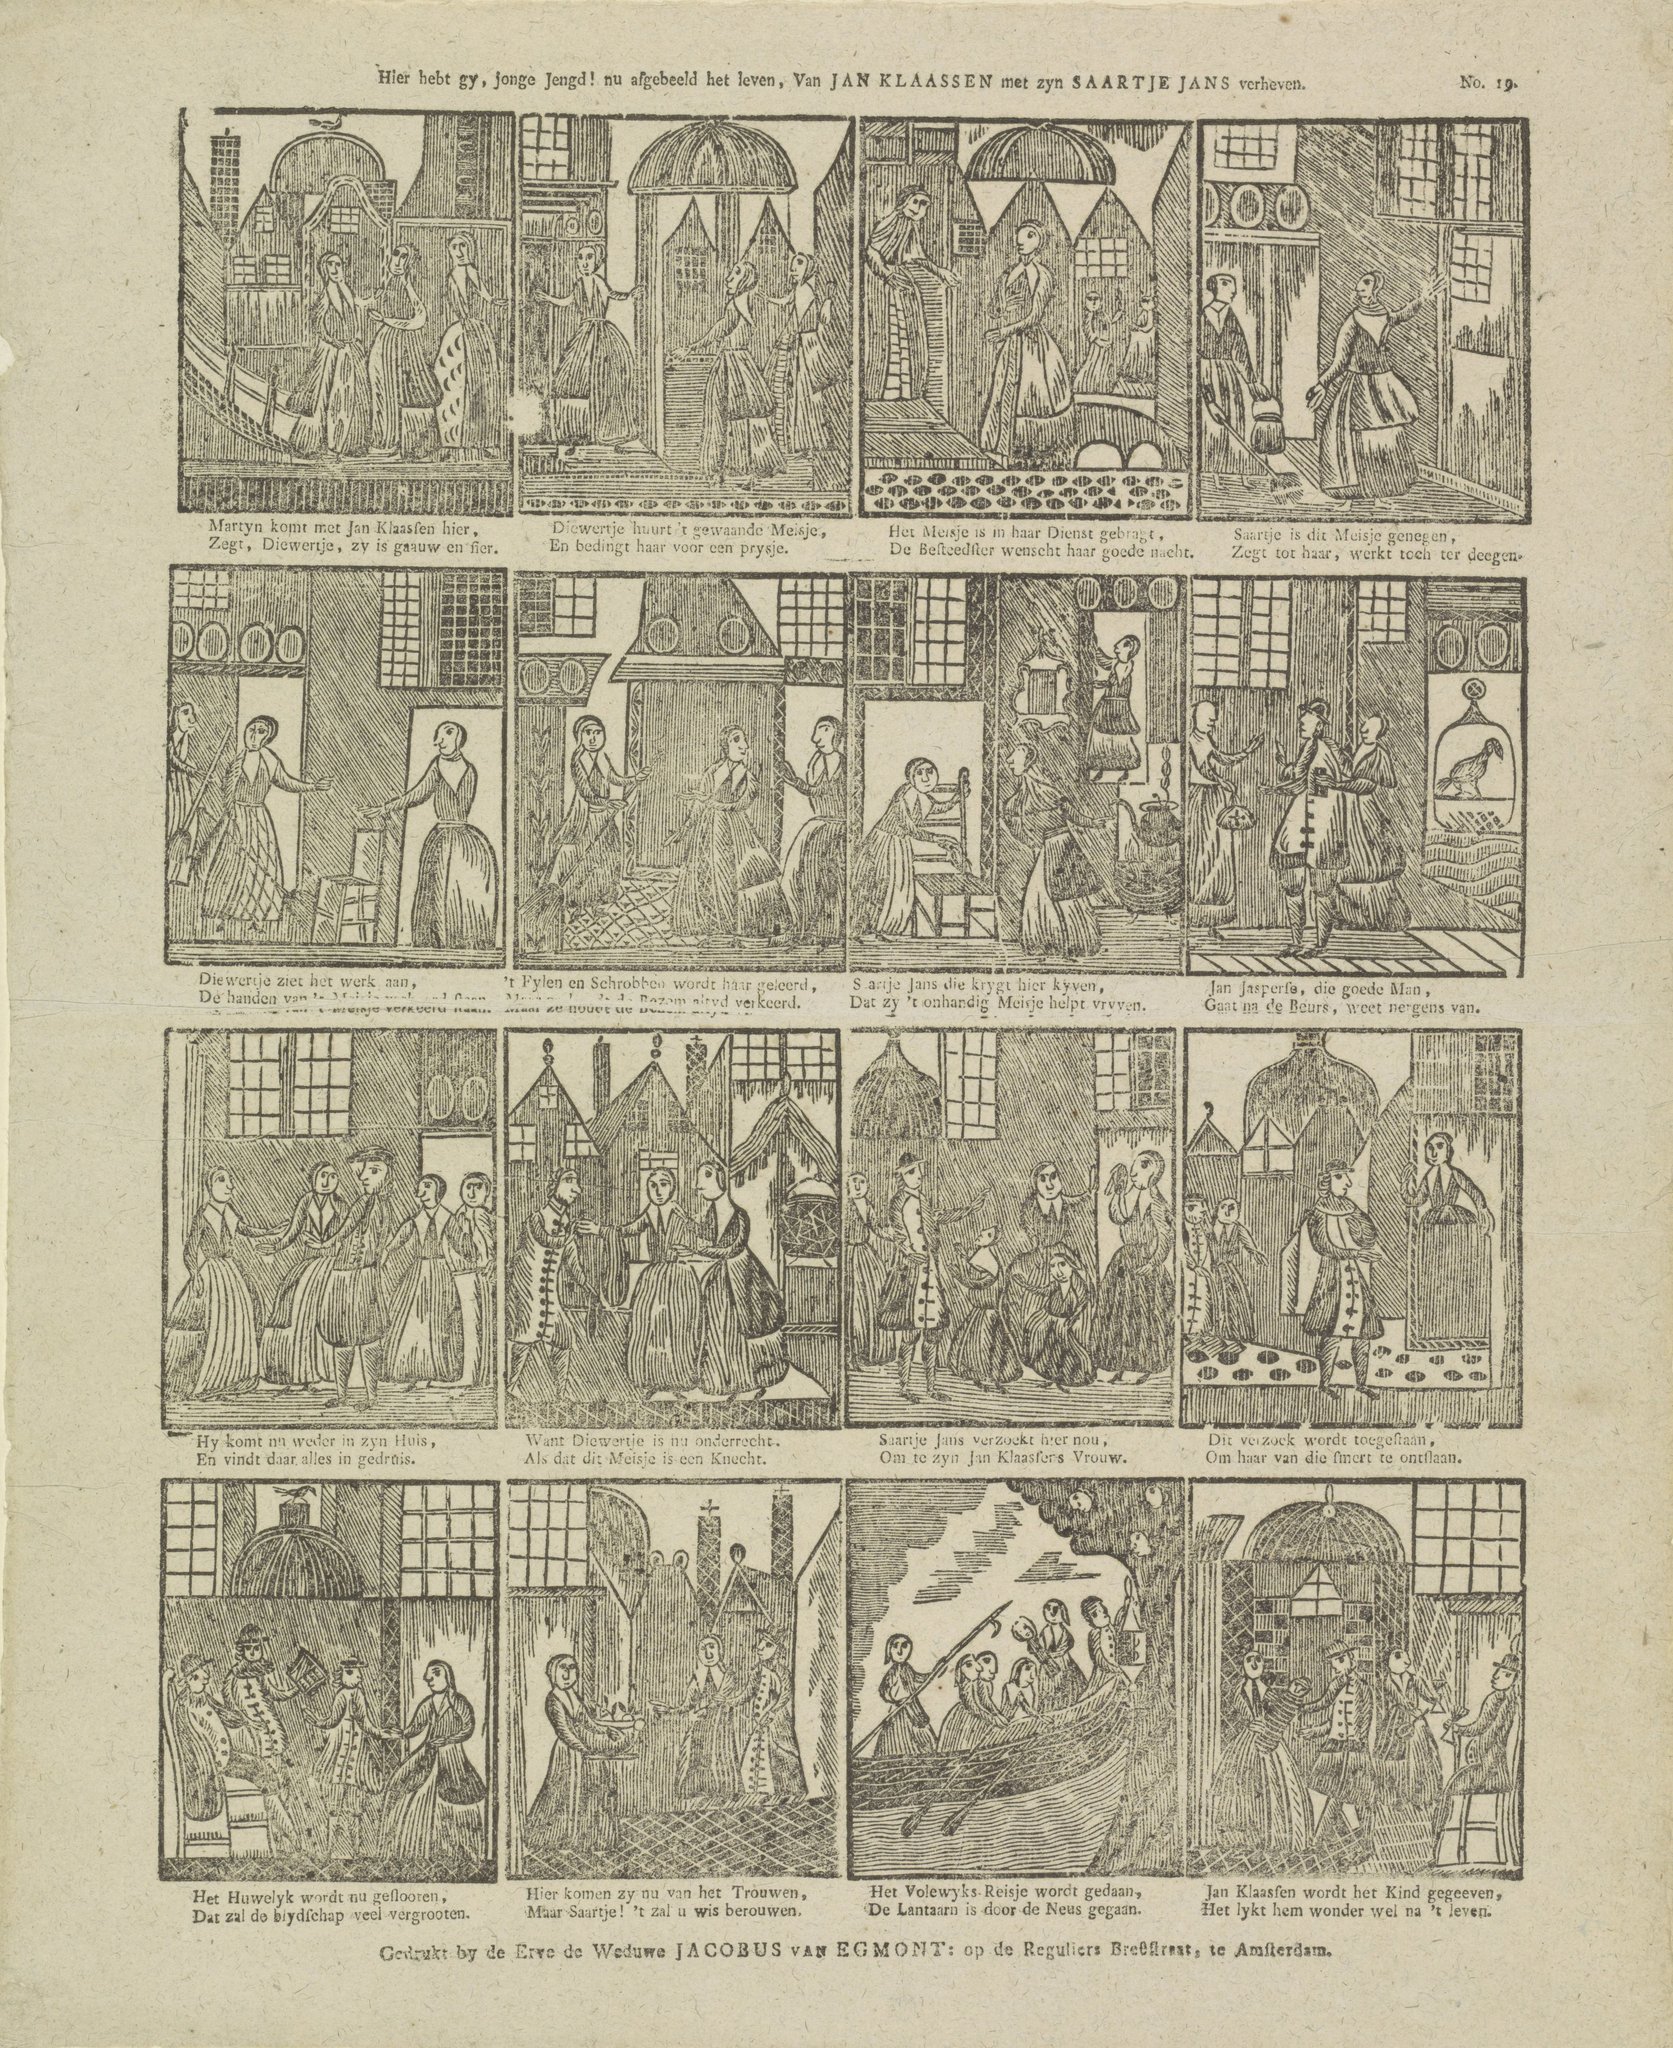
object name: print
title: Hier hebt gy, jonge jeugd! nu afgebeeld het leven, van Jan Klaassen met zyn Saartje Jans verheven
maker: Anonymous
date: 1761-1804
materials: paper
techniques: letterpress printing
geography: amsterdam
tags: punch and judy, tales and fairy tales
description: Blad met 16 voorstellingen over het leven van Jan Klaassen en Saartje Jans. Onder elke voorstelling een tweeregelig vers. Genummerd rechtsboven: No. 19.